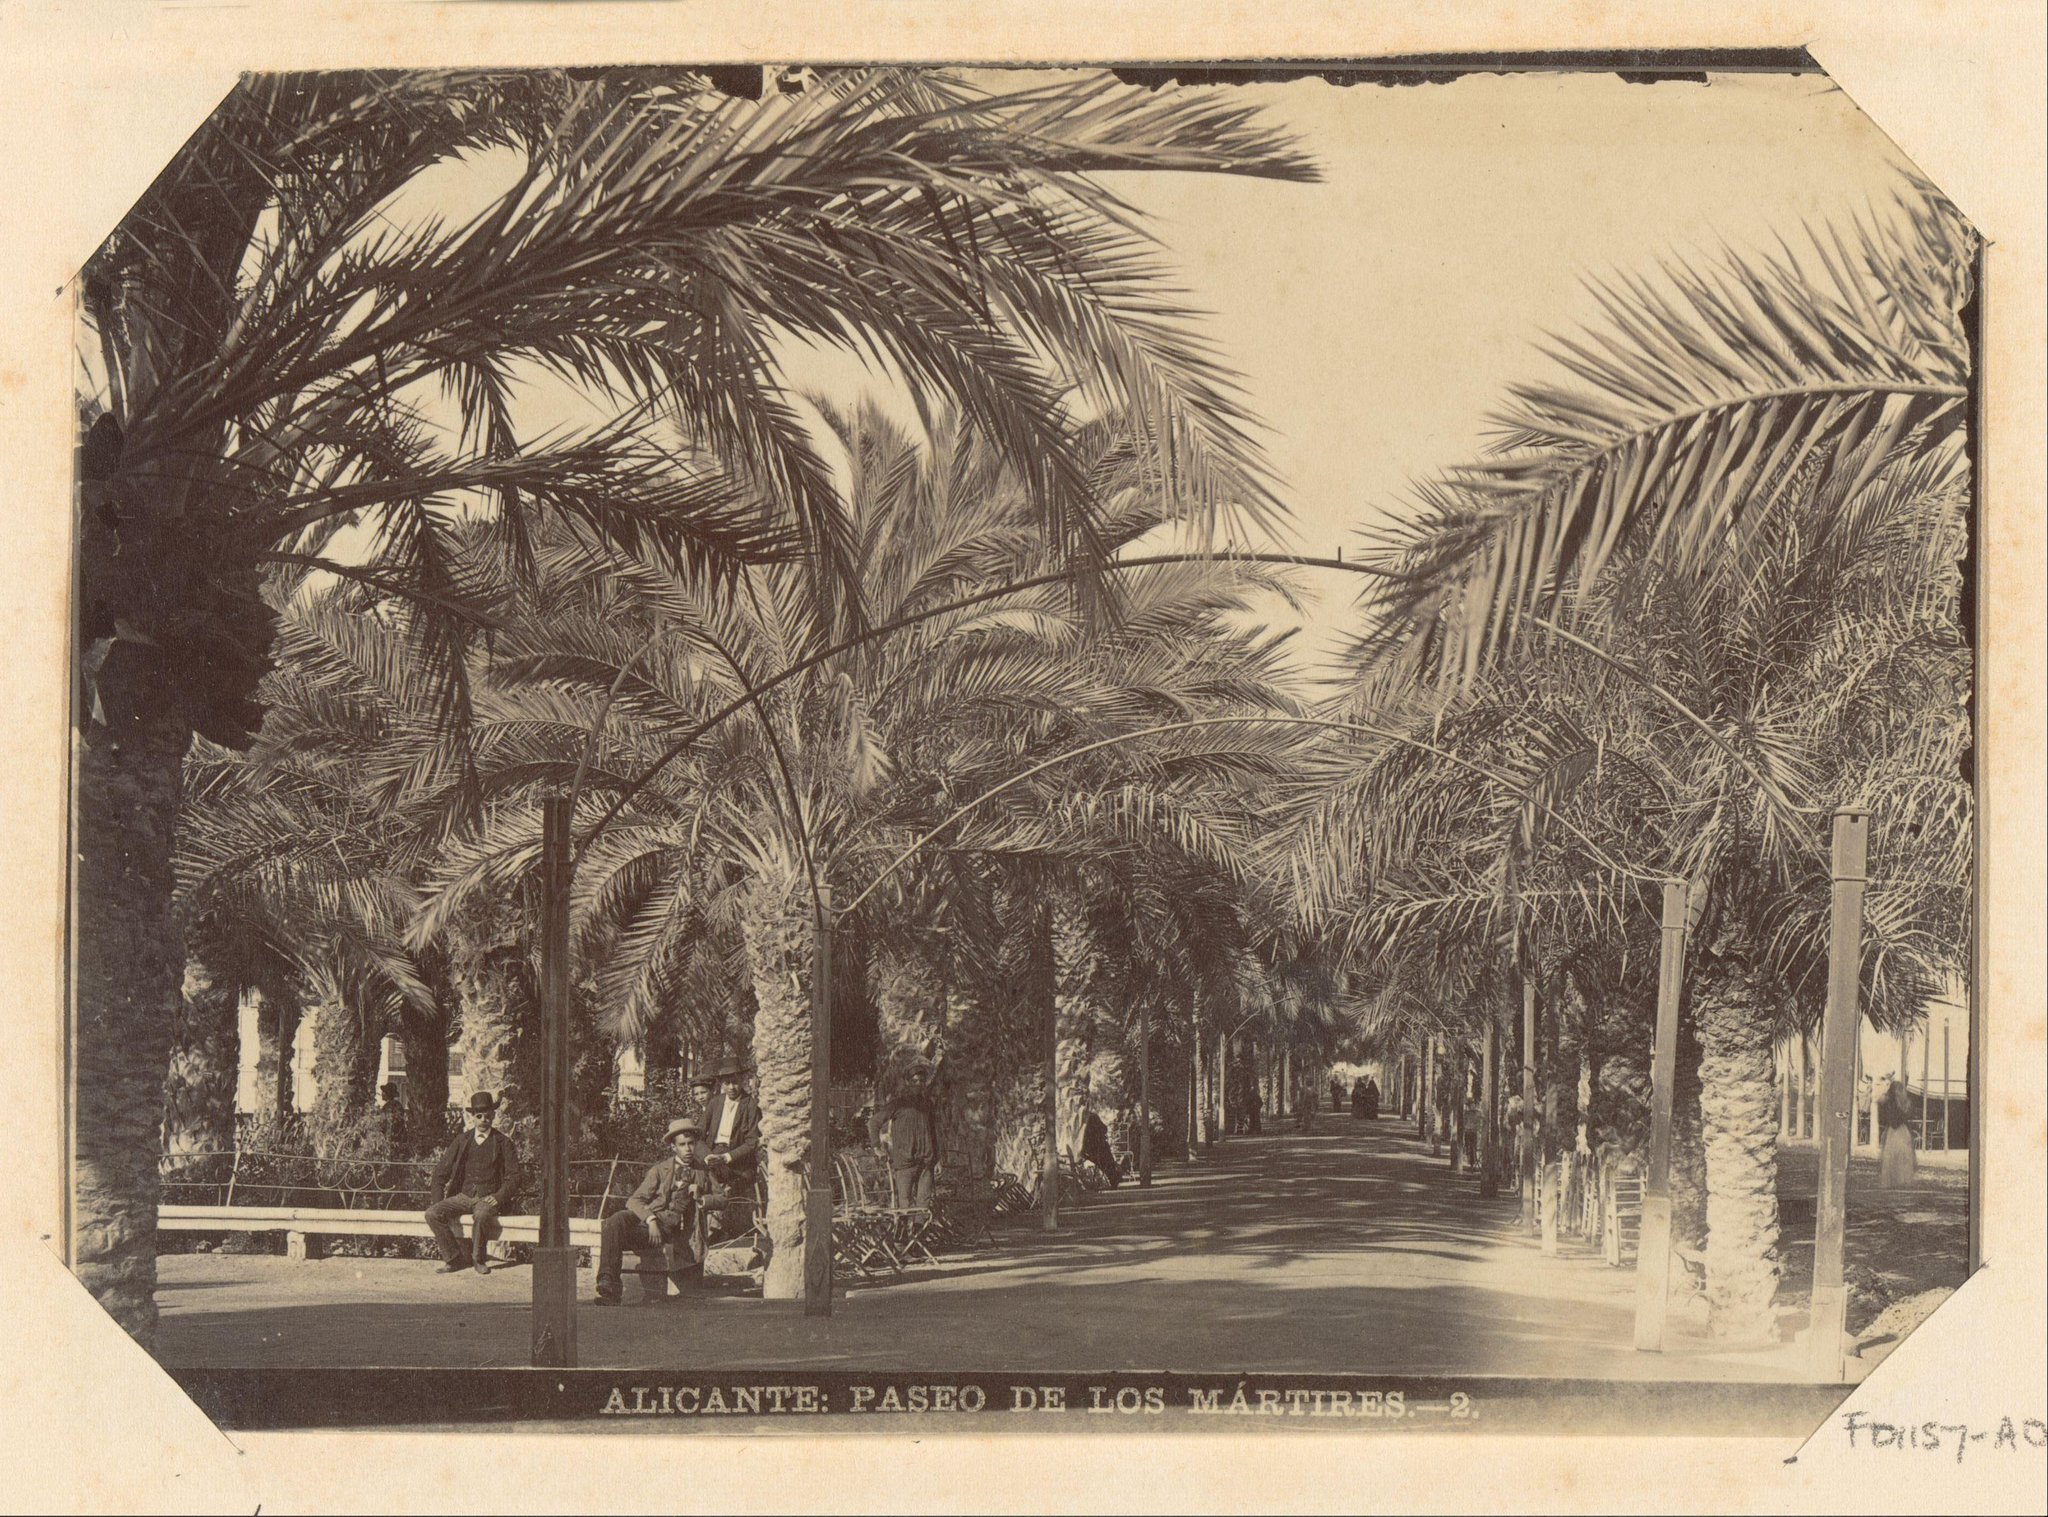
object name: album leaf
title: Straatgezicht van Paseo de los Mártires de la Libertad te Alicante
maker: Anonymous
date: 1885-1892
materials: photographic support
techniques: albumen print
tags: trees: palm-tree, street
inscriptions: number: ‘2.’, annotation: ‘Alicante - Paseo de lis Martires’